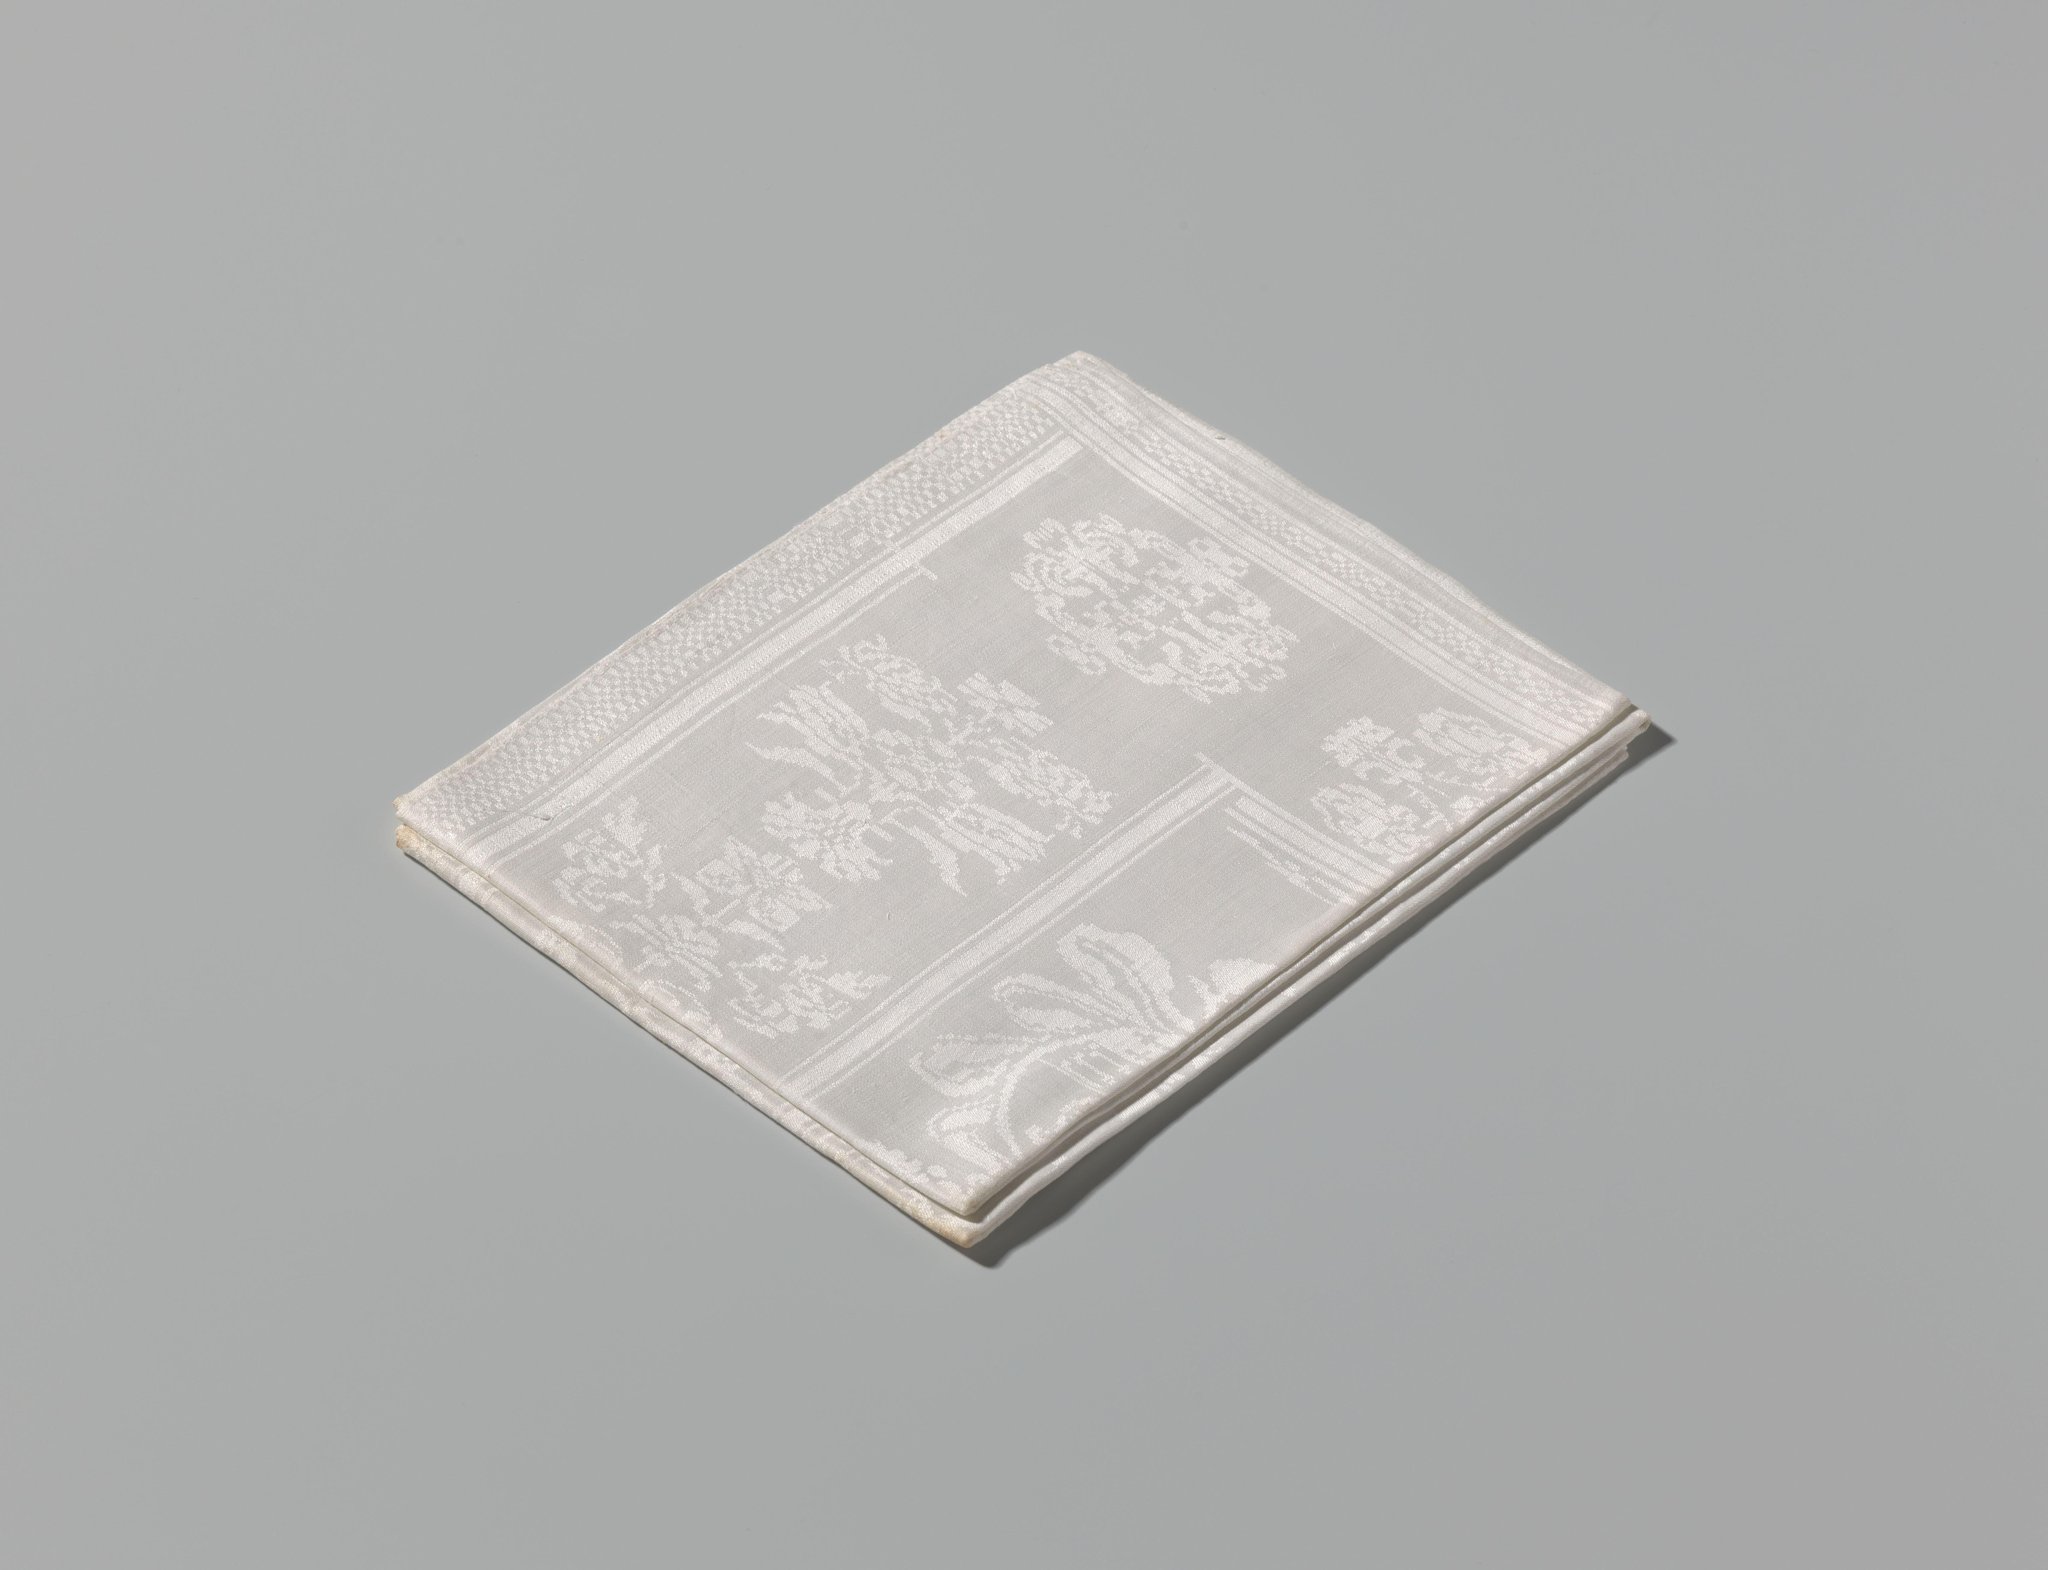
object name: napkin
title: Servet van wit linnendamast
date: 1706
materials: linen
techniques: damask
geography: flanders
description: Wit linnen damasten servet met taferelen uit de Spaanse Successie-Oorlog en de inweving "PRINC ET DVX DE MARLOBORVGH BELGIVM DEBELLAVIT" en "ANVERS", "MALINIS", "BRVSSEL", "LOVEN", "GENDT", "BRVGGE", "OSSTENDE" en "MEENEN".